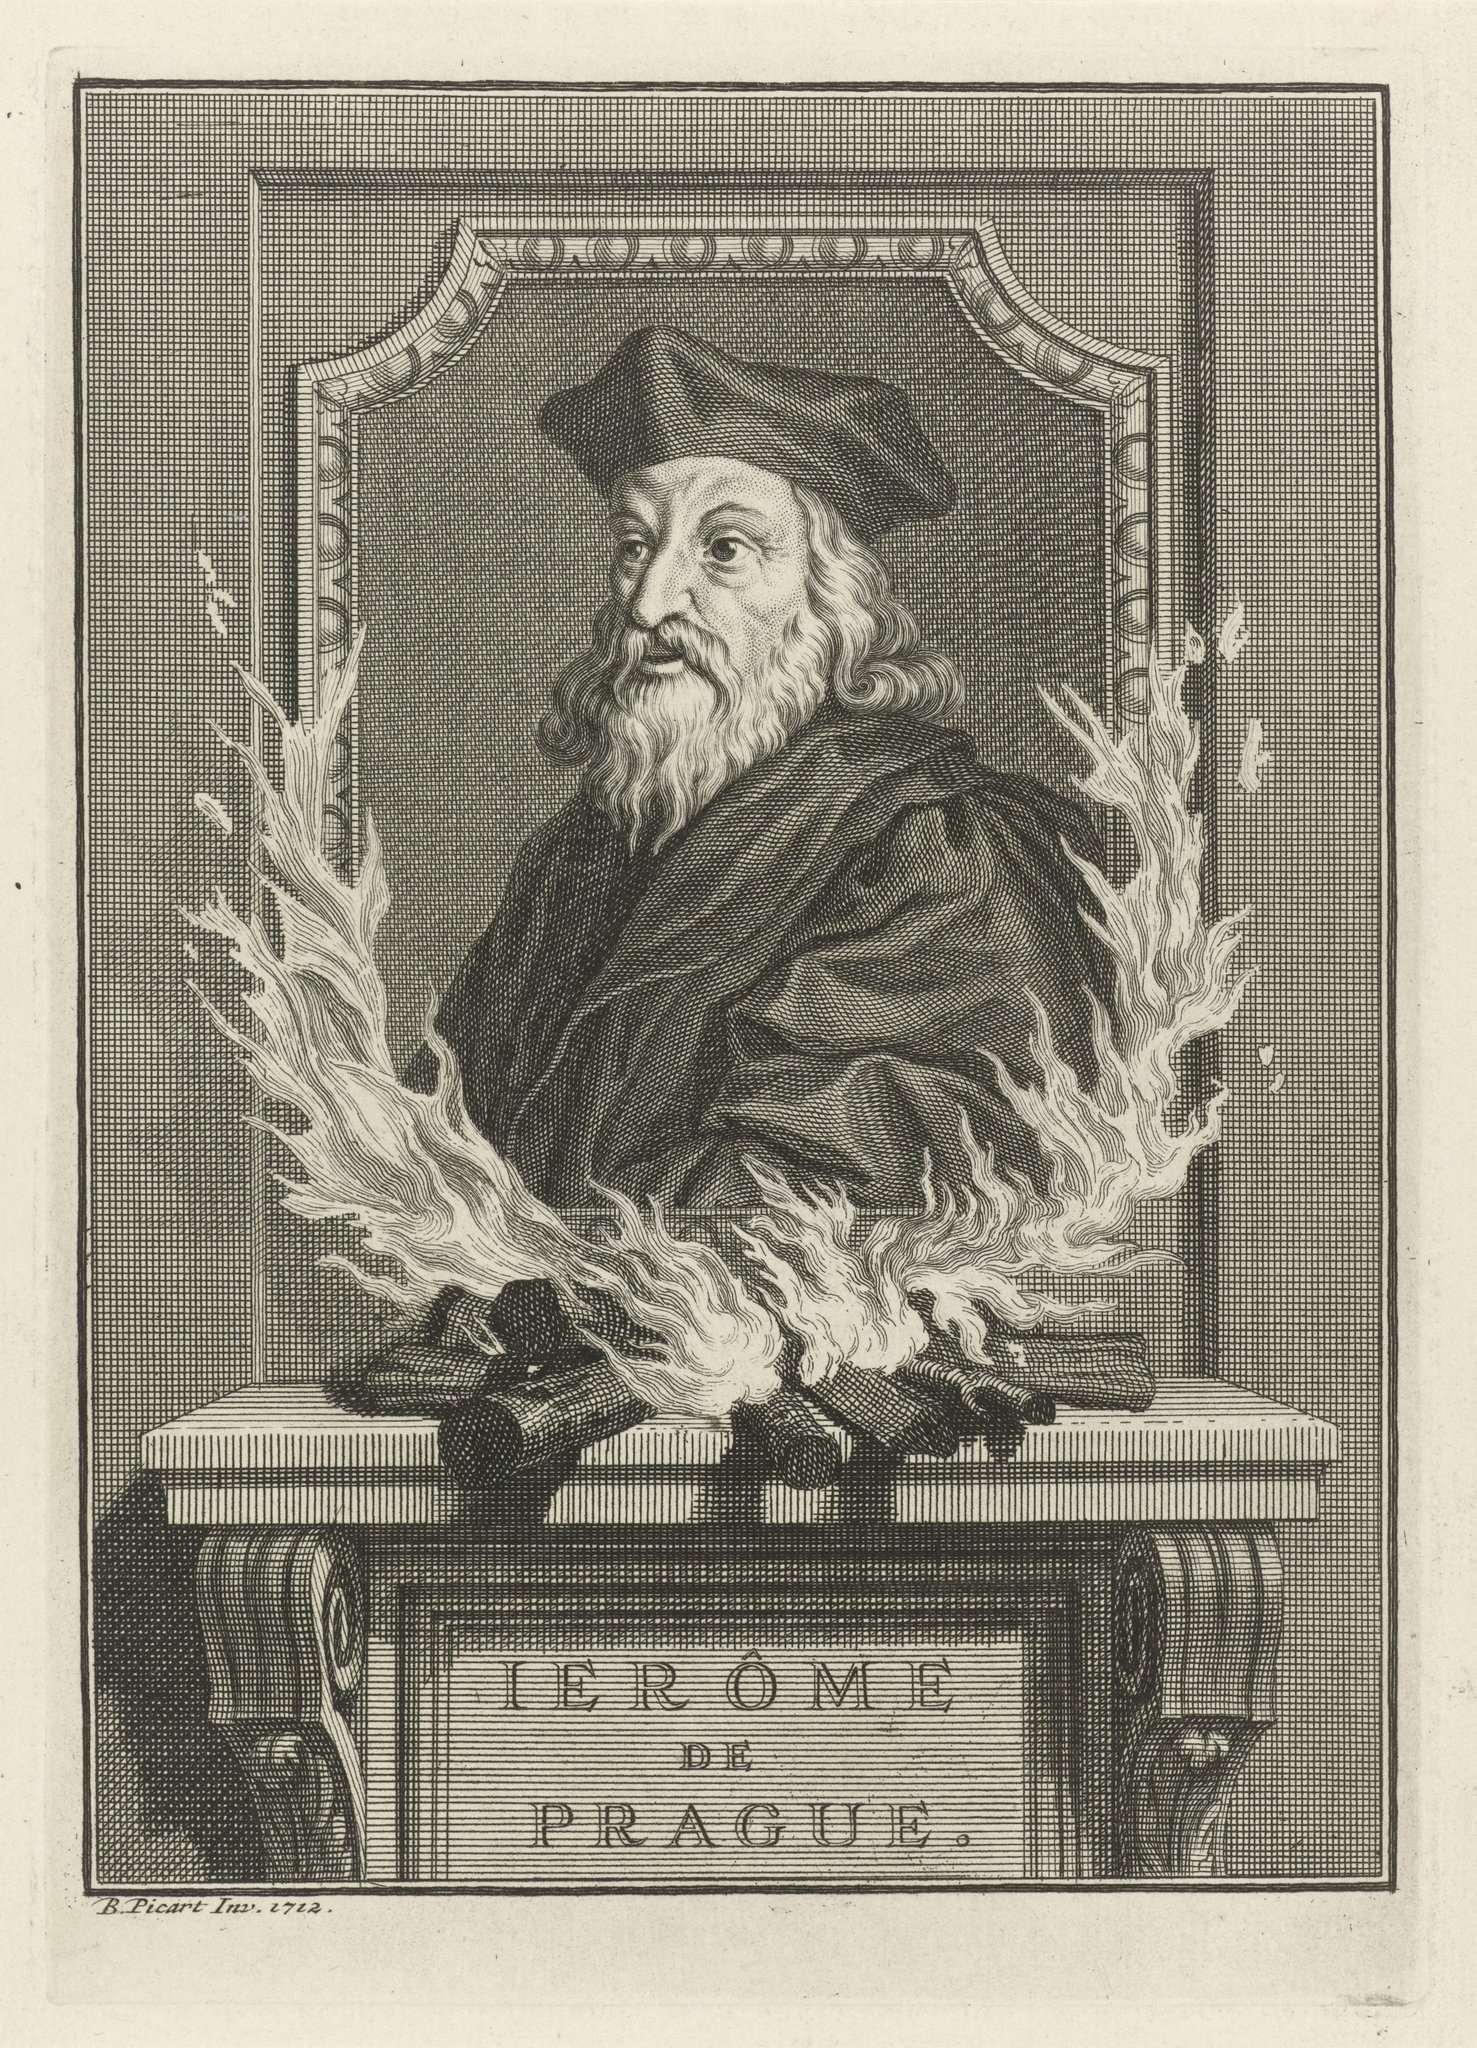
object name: print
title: Portret van Hiëronymus van Praag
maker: bernard picart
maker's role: draughtsman, print maker, publisher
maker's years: 1673-1733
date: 1712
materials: paper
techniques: engraving, etching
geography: amsterdam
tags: prague, open fire (in general)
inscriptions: collector's mark: Lugt 2228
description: Portret van Hiëronymus van Praag, Boheems geleerde en medeoprichter van de Hussieten. Op de piëdestal een brandend vuur, als verwijzing naar zijn dood op de brandstapel.